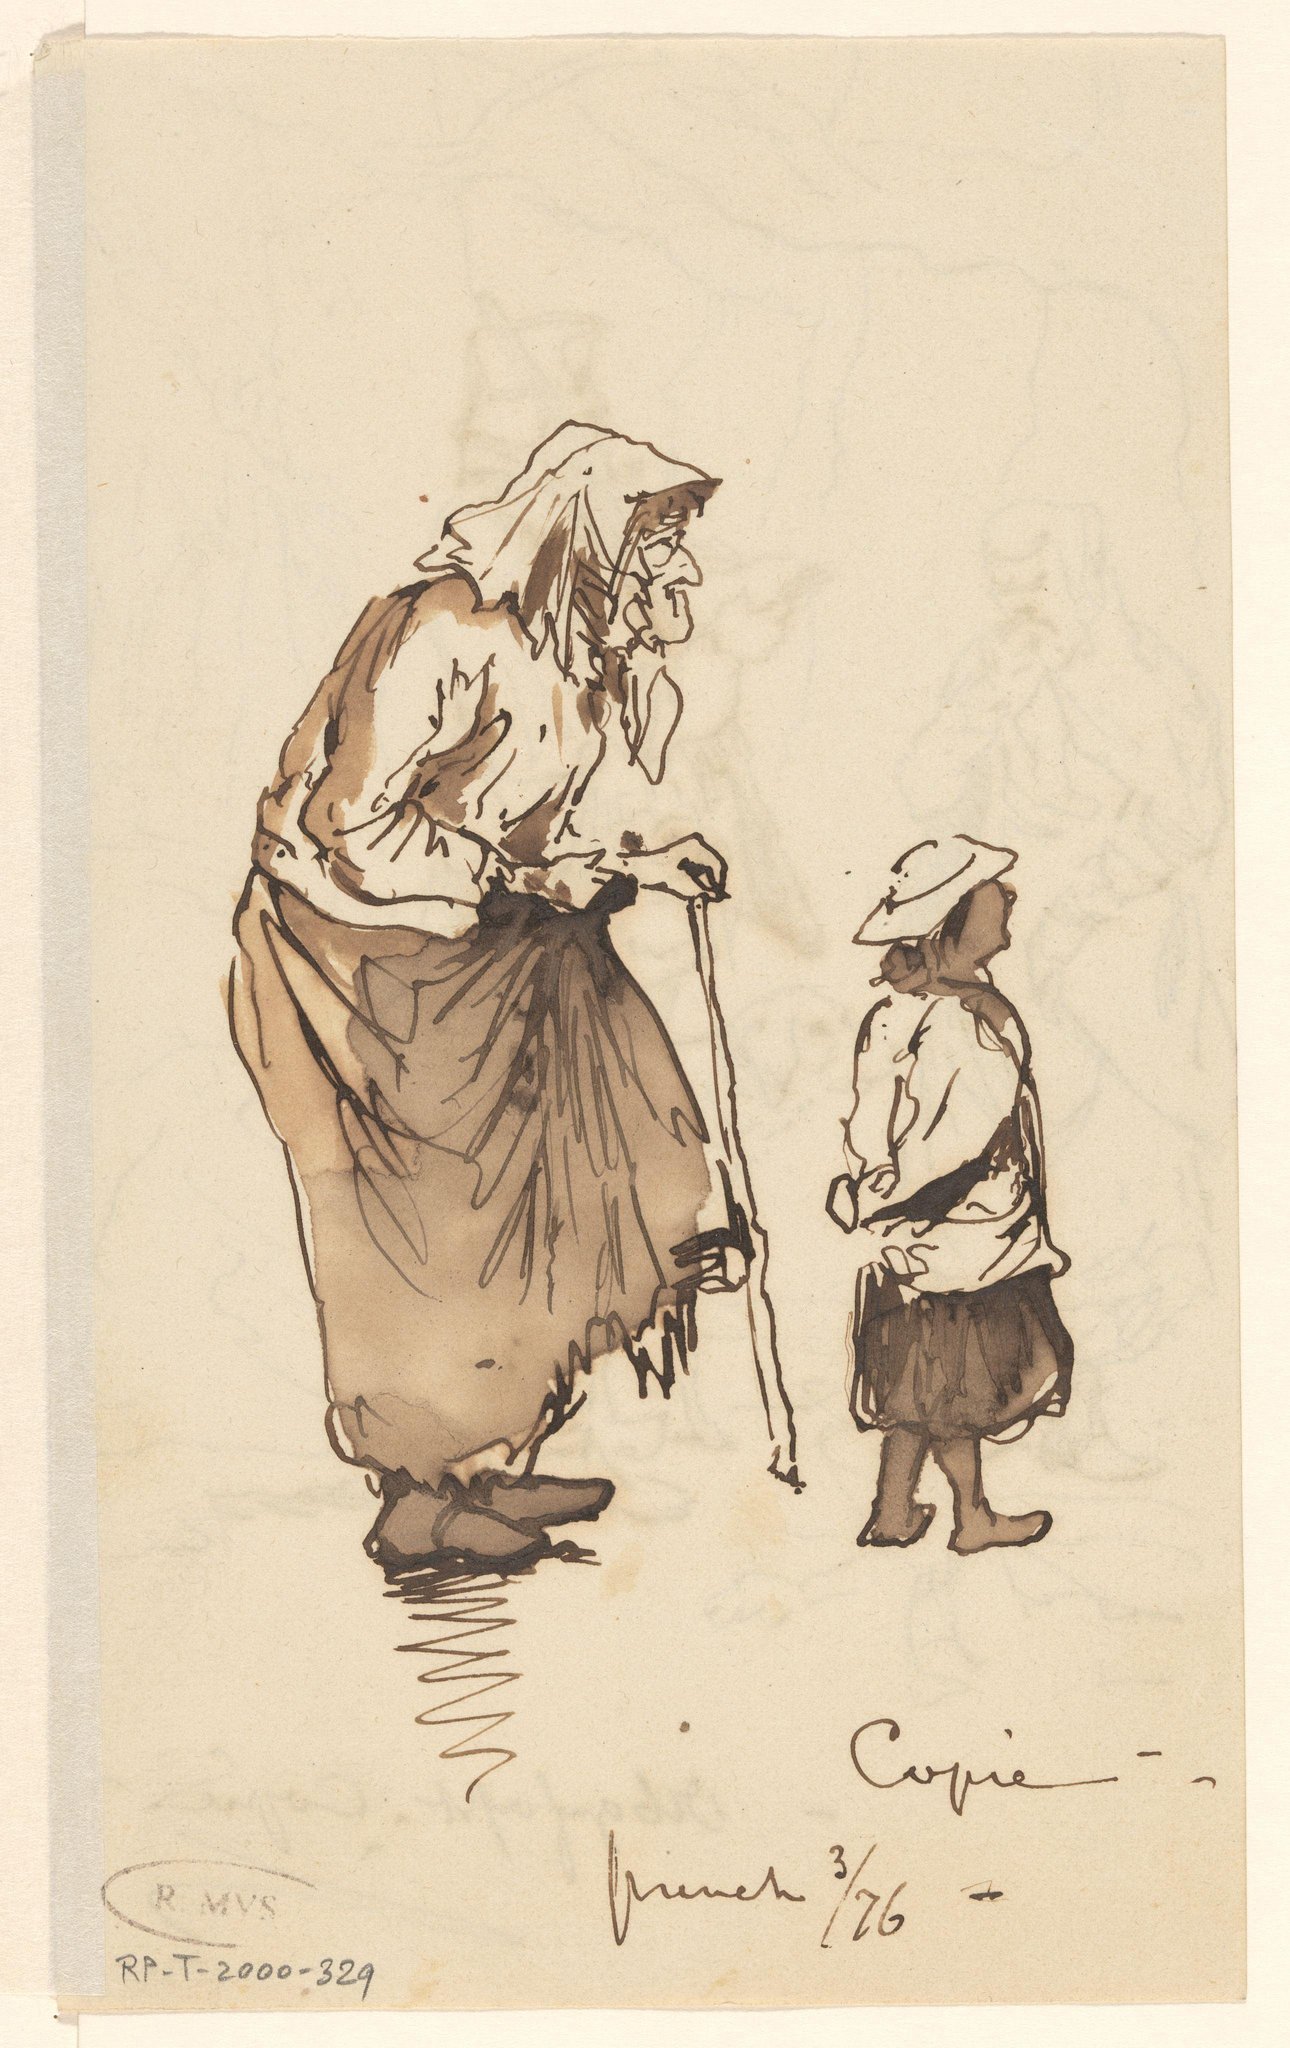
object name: drawing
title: Oude vrouw en jong meisje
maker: johannes tavenraat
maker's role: draughtsman, painter, print maker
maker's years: 1809-1881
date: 1803-1876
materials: ink, paper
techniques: brush, pen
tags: girl (child between toddler and youth), old woman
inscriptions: date and inscription: ‘...foßt - Copie / ... 3/76’, collector's mark: Lugt 2228